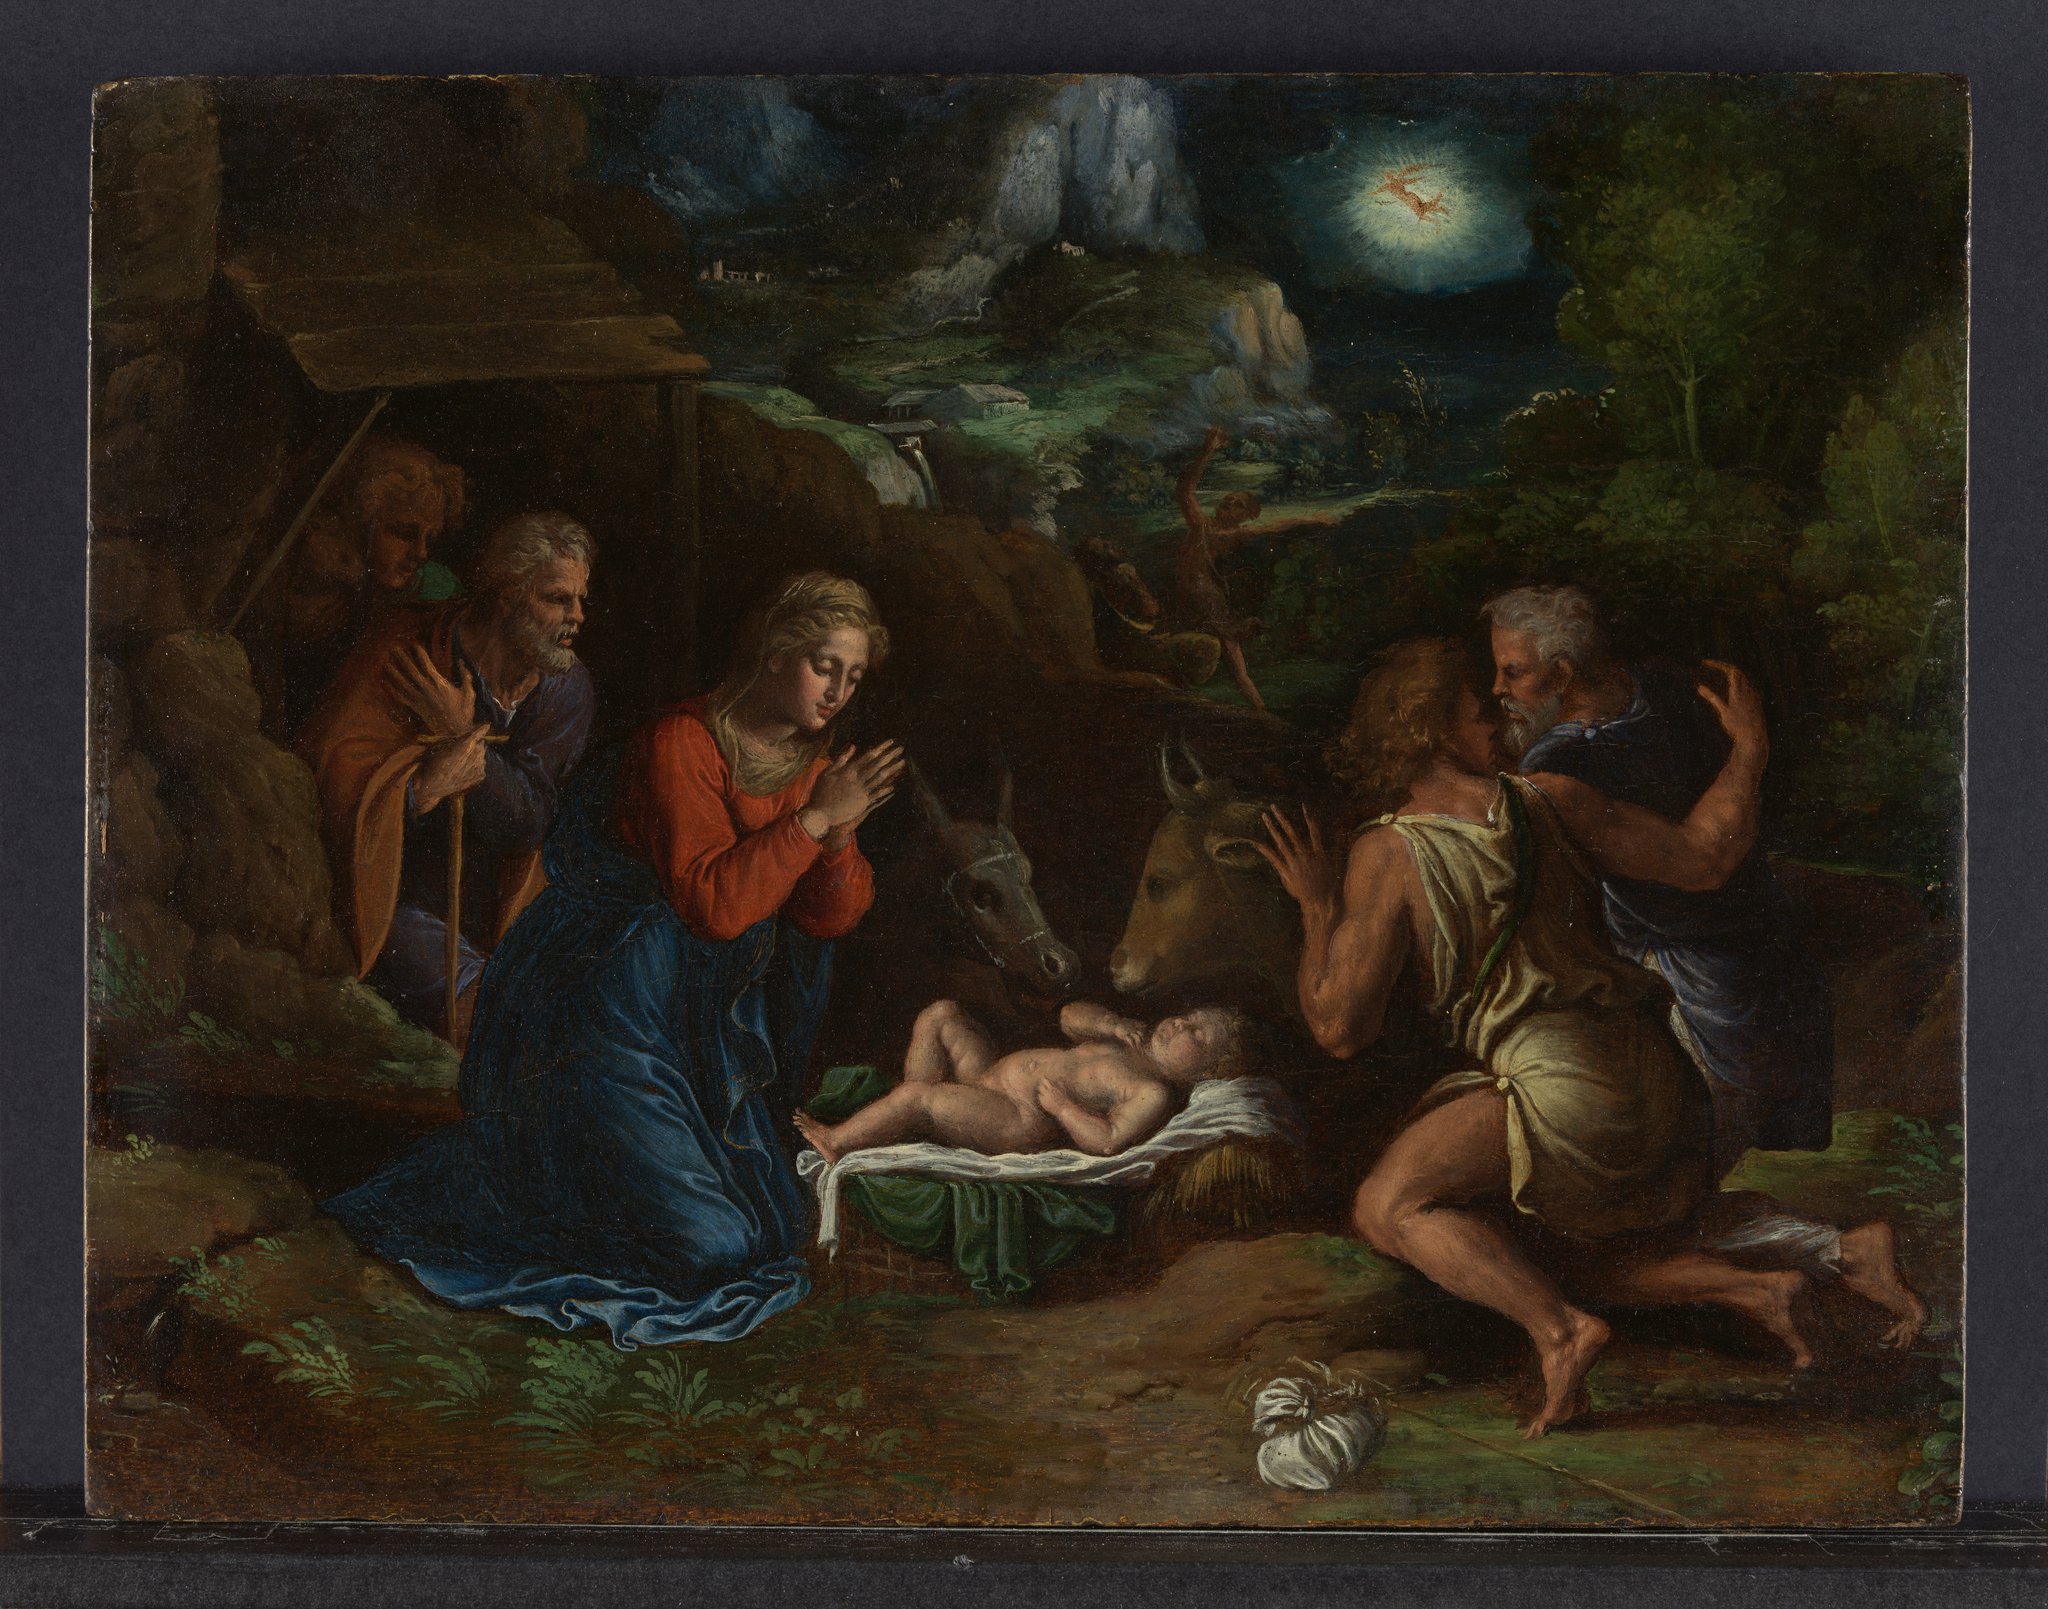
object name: painting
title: The Adoration of the Shepherds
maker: girolamo da carpi (girolamo sellari)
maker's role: artist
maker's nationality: italian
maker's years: 1501-1556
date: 1535-1540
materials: oil, wood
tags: cows,donkeys,virgin mary,jesus,adoration of the shepherds,joseph